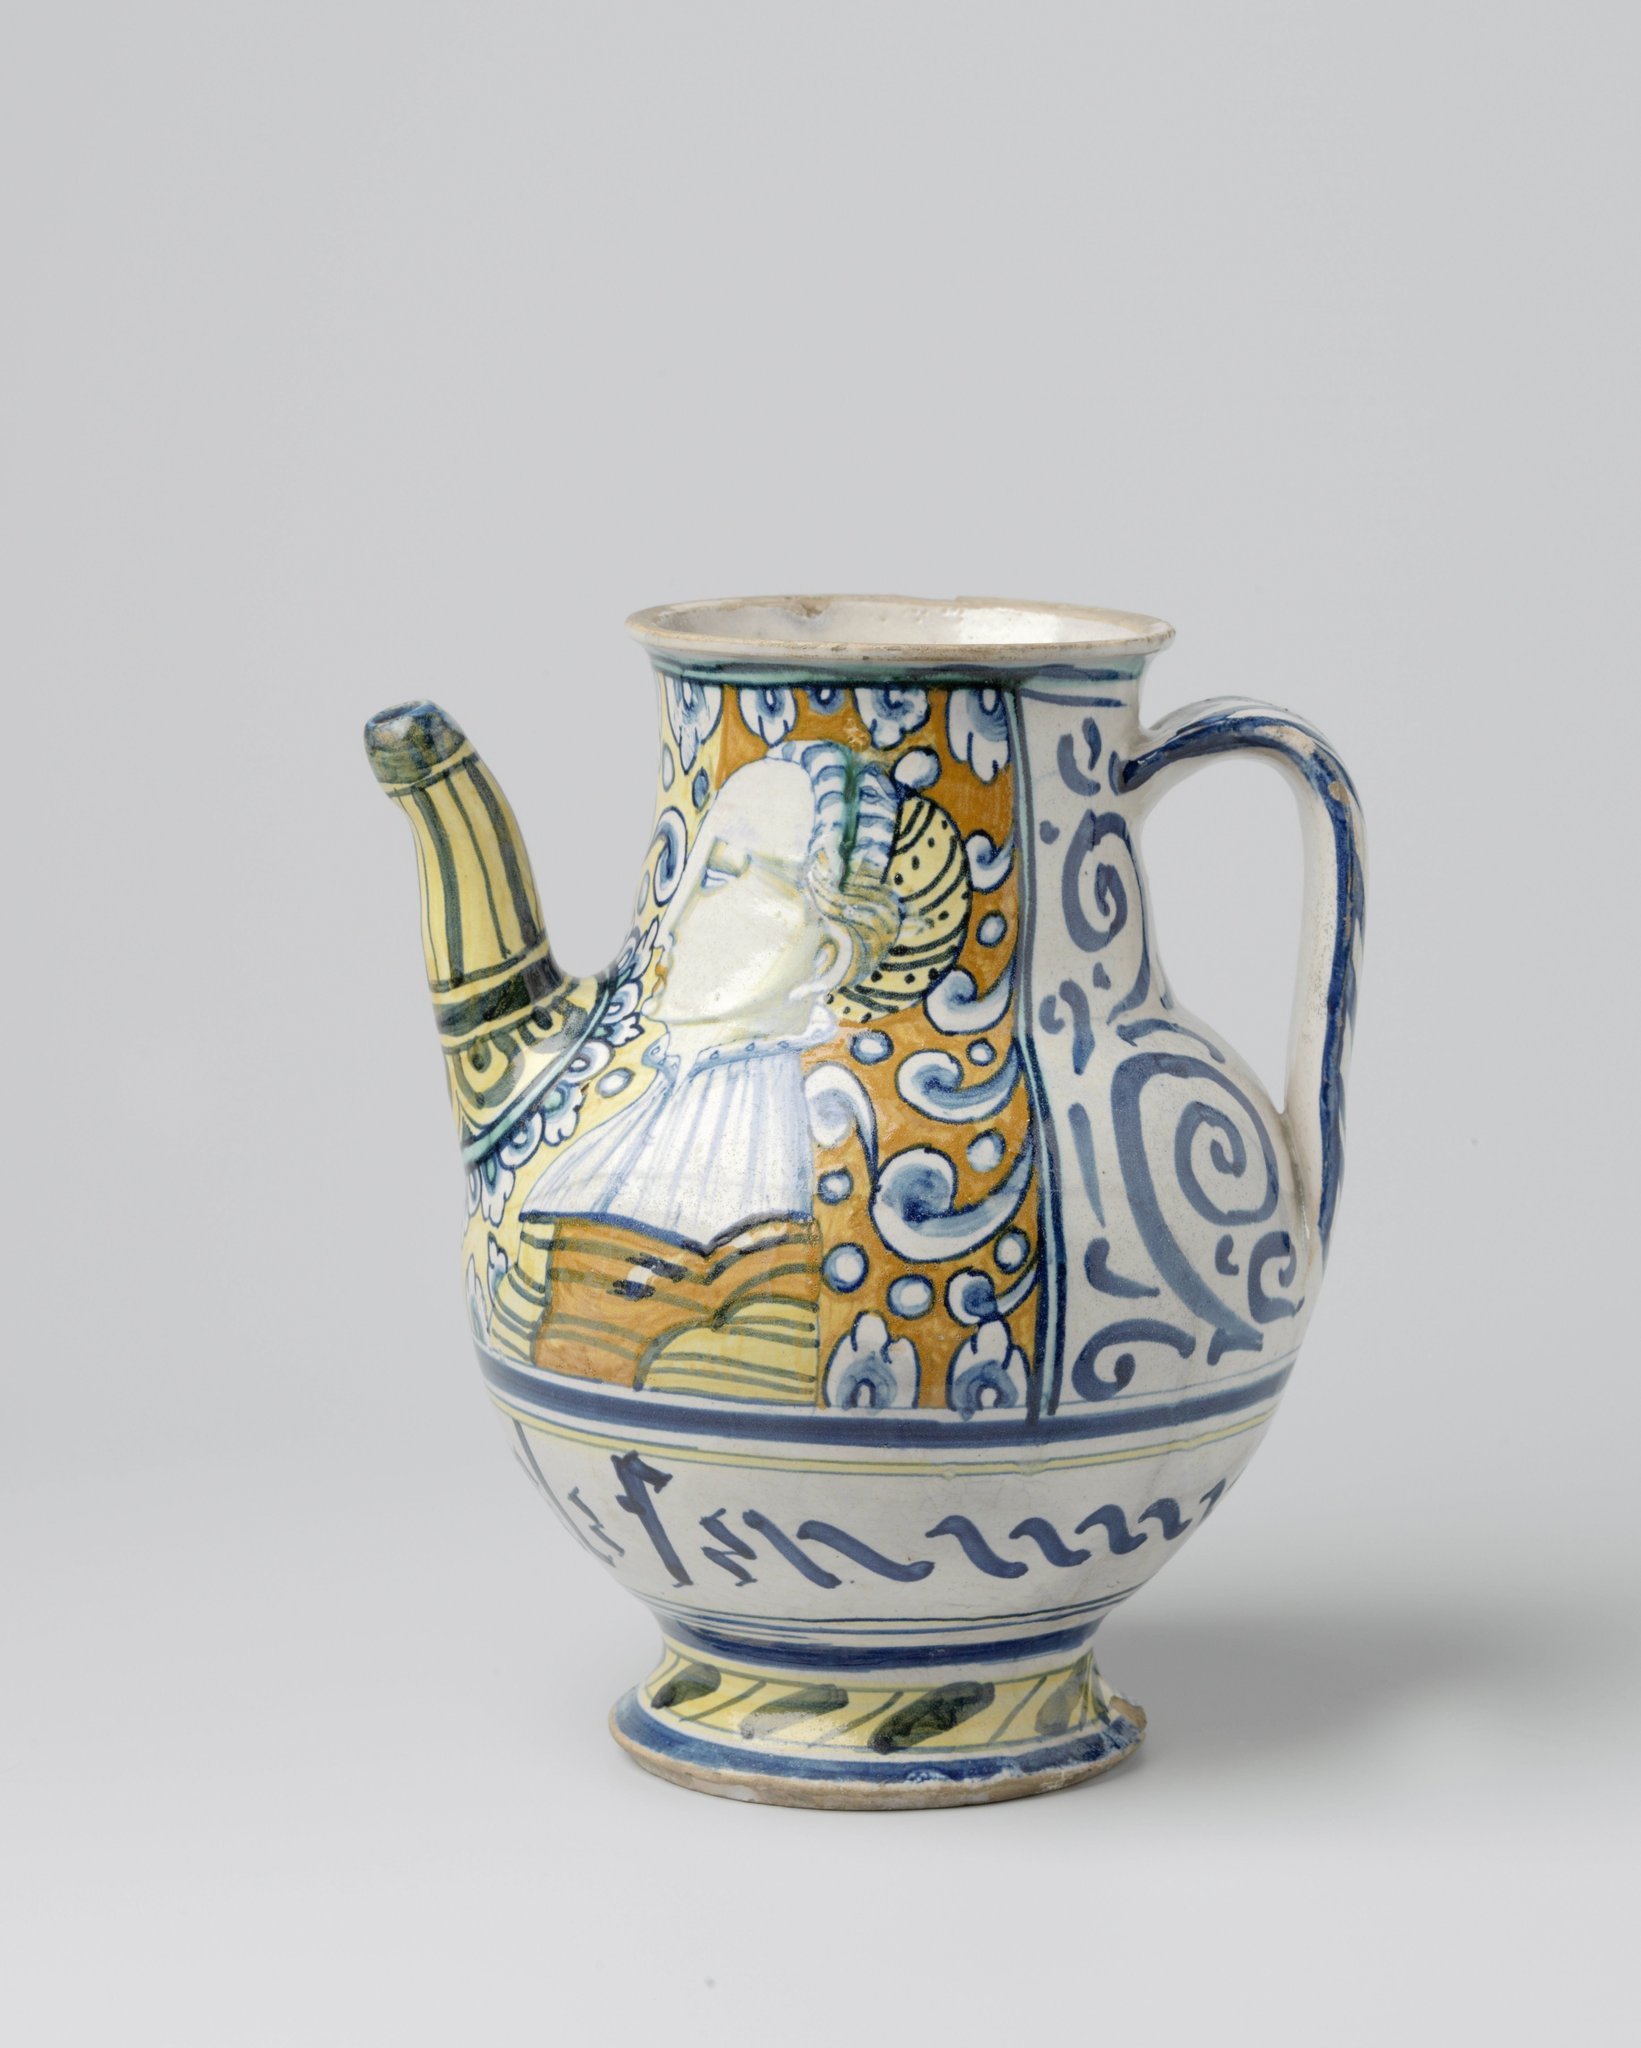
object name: ewer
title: Kan, omgekeerd balustervormig met aan beide zijden een vrouwsportret en profil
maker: Anonymous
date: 1530-1560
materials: earthenware, glaze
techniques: maiolica, painted, polychromy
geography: castelli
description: Syrup jar inscribed OXIMEL S (sour honey drink). Castelli, c. 1530 - 1560.